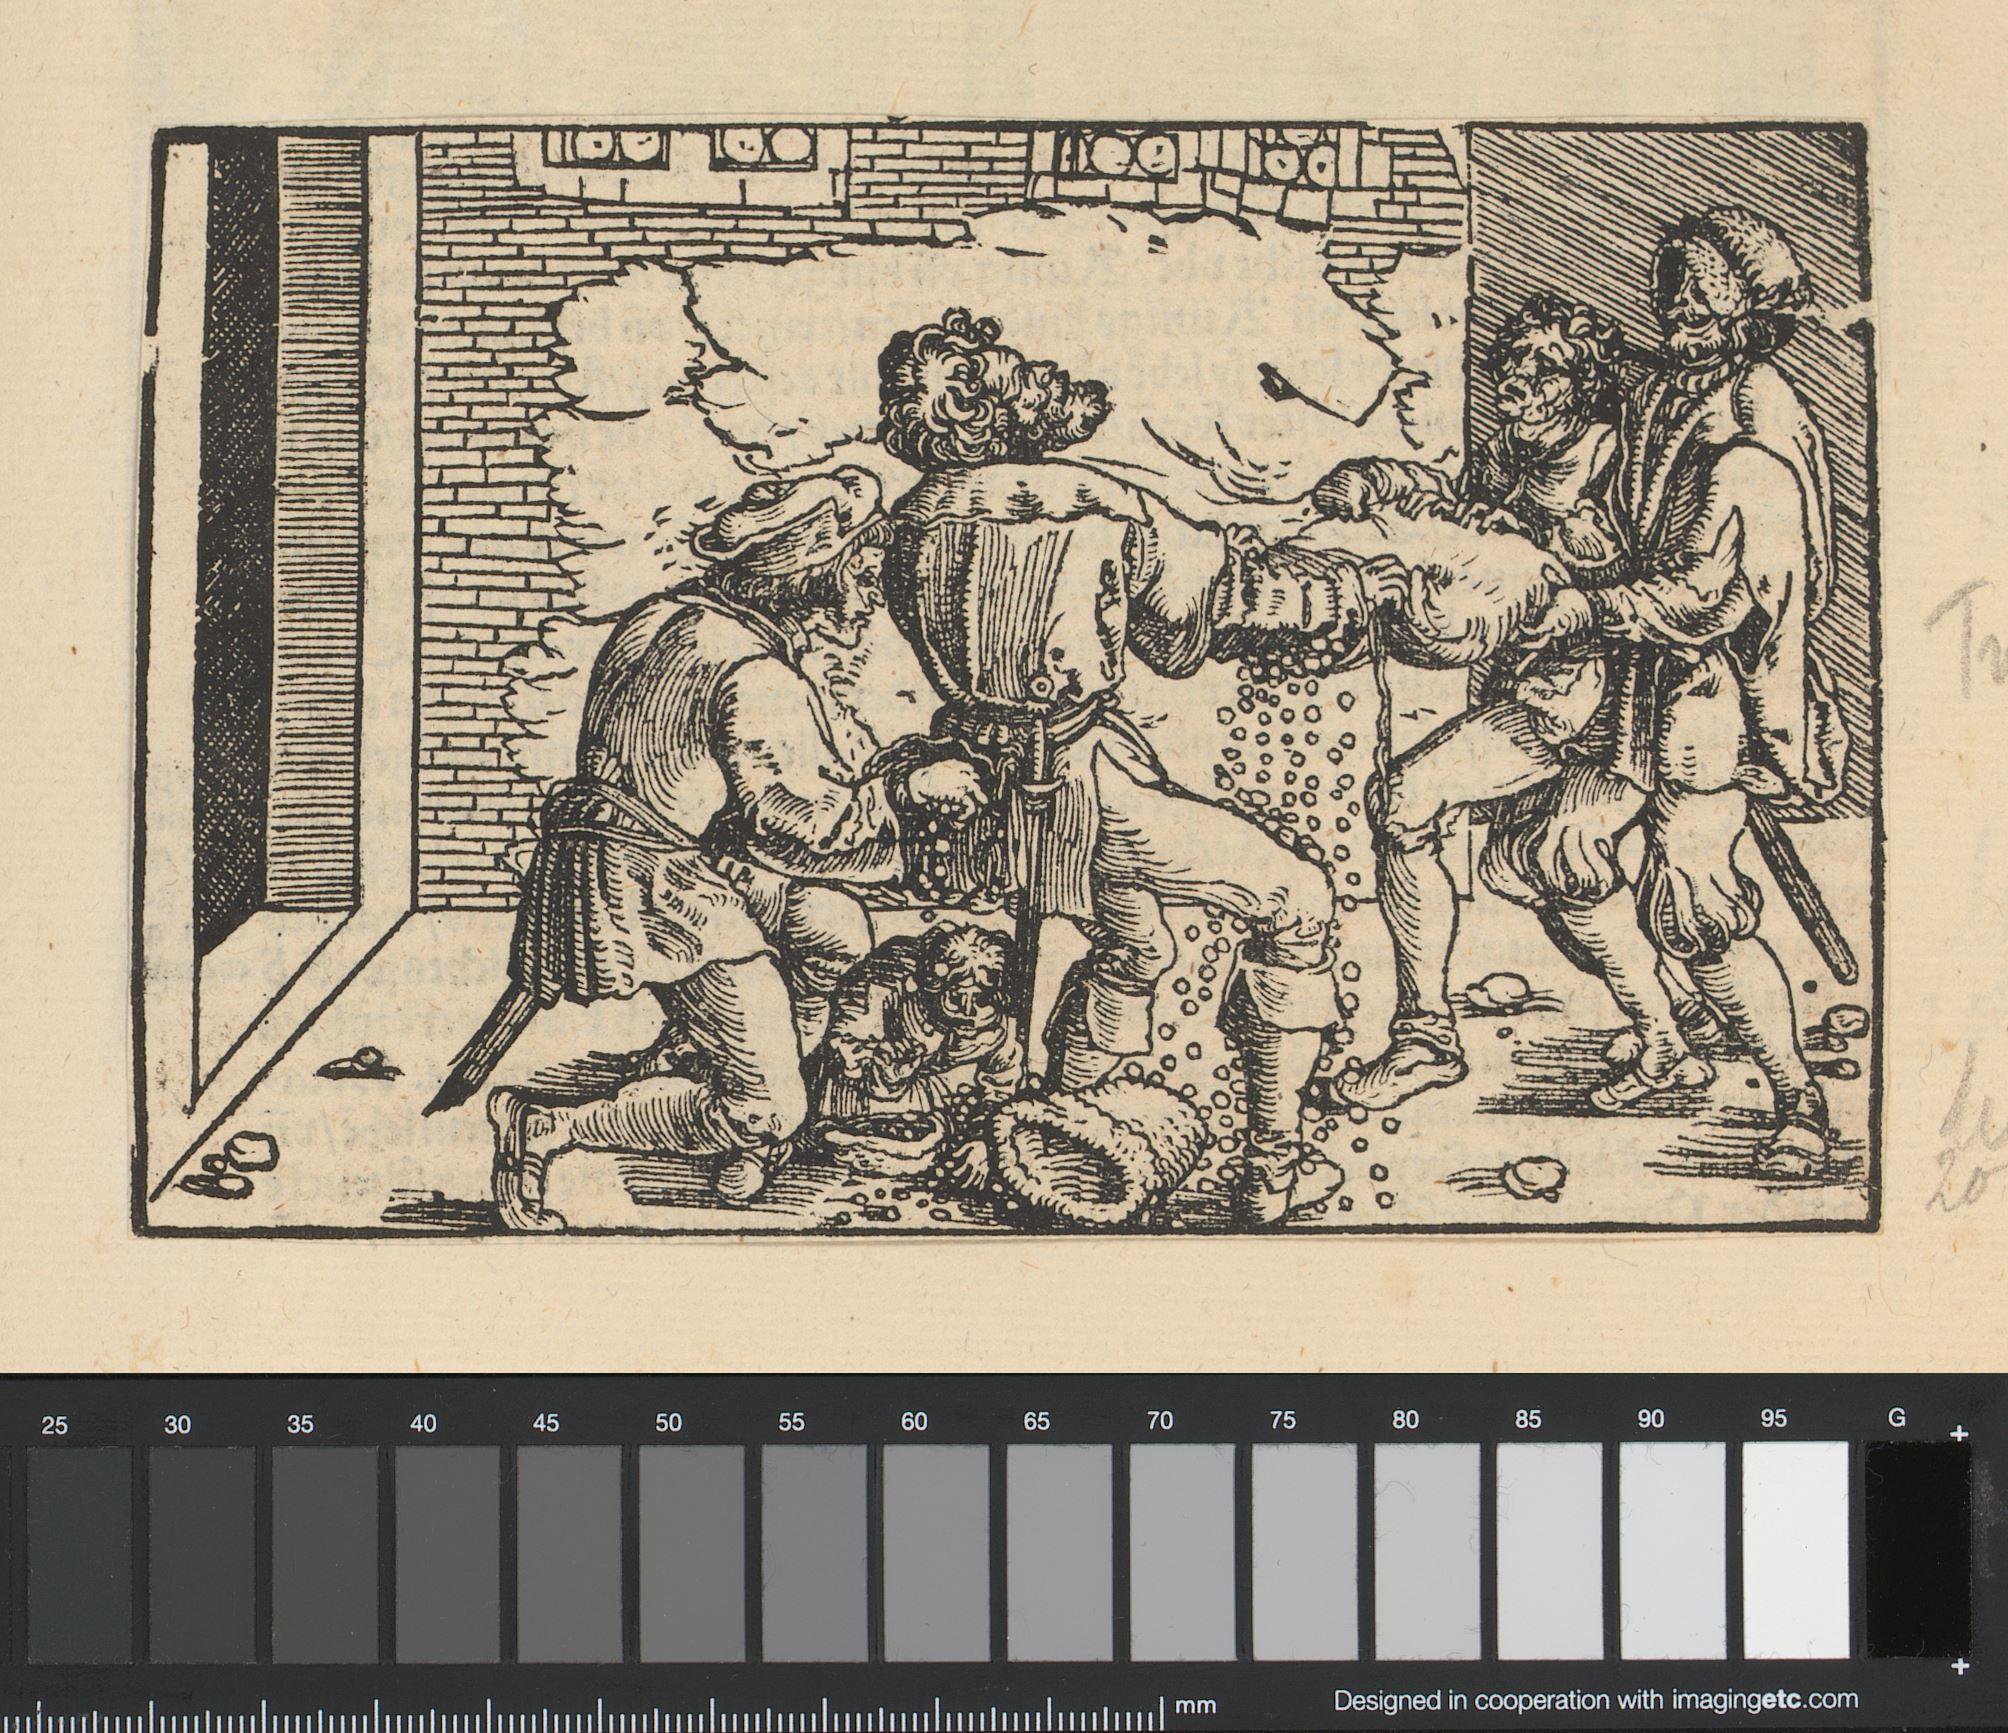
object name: album leaf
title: Man wordt van zijn geld beroofd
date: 1514-1532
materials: paper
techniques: letterpress printing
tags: theft, robbery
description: Deze prent is gebruikt in: Petrarca, Francesco. Von der Artzney bayder Glück, des guten und widerwertigen: unnd weß sich ain yeder inn Gelück und Unglück halten sol (...). Augsburg: Heinrich Steiner, 1532. Deze uitgave is ook bekend onder de titel 'Trostspiegel in Glück und Unglück'. Deze prent is ook gebruikt in: Cicero, Marcus Tulius. Officia M.T.C. Ein Buch so Marcus Tullius Cicero der Römer zu seynem (...). [Vertaald uit het Latijn door] Johann von Schwarzenberg. Augsburg: Heinrich Steiner, 1531.